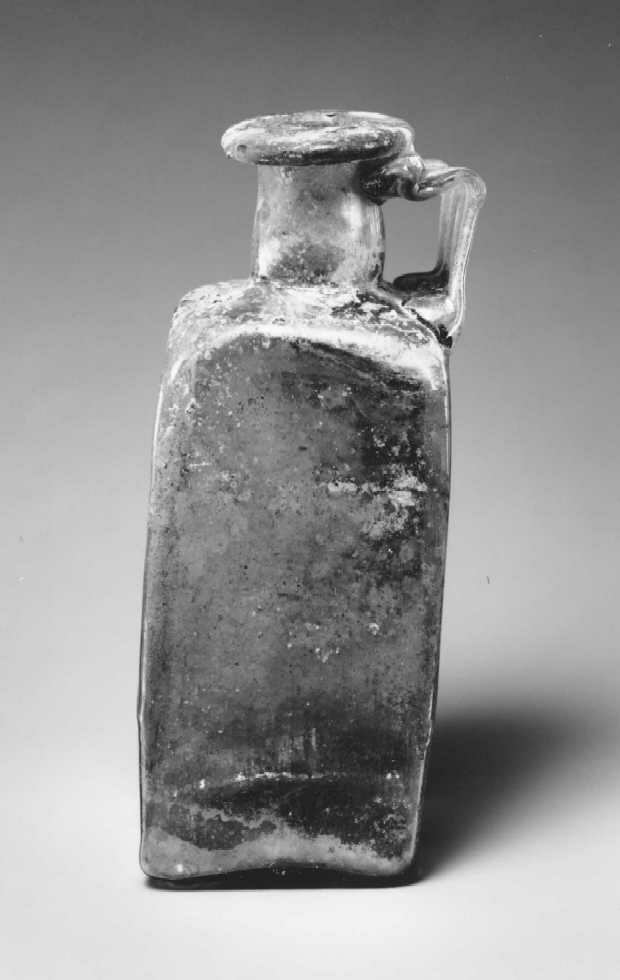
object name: bottle, square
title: Glass square bottle with base inscription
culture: roman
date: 101-200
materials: glass